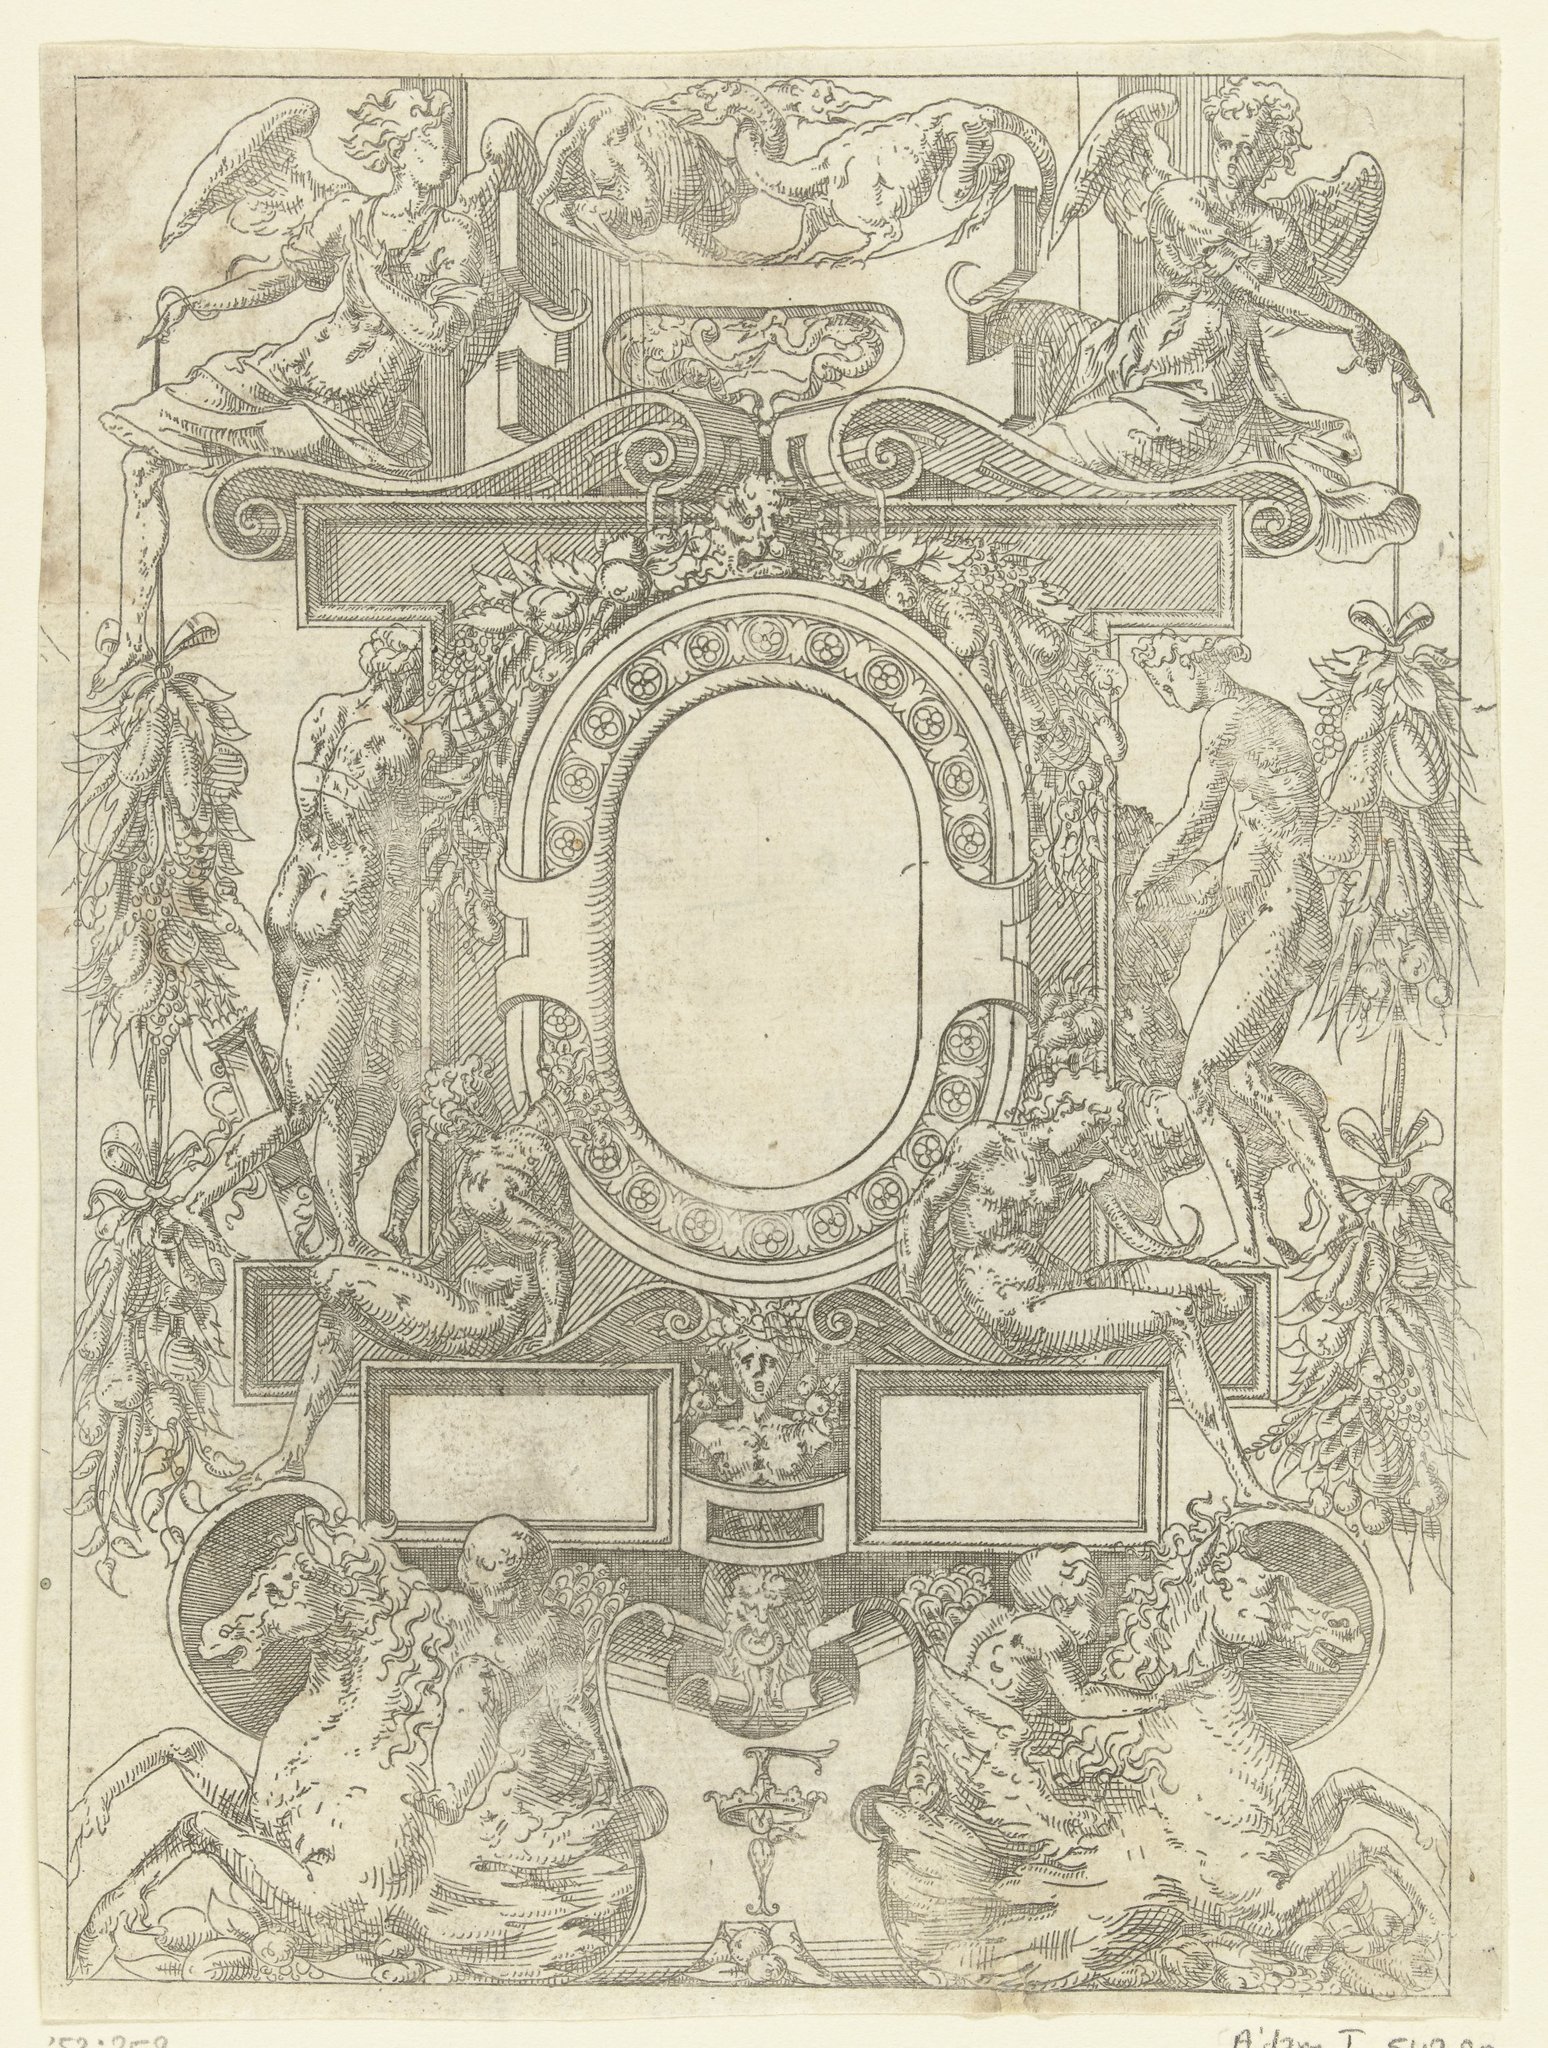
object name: print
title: Kleine cartouche naar voorbeeld te Fontainebleau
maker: Anonymous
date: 1520-1584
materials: paper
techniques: etching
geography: italy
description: Linksonder en rechtsonder rijdt een putto op een gevleugeld paard. Uit serie van 32 bladen. De cartouches zijn deels ontleend aan de prenten van Antonio Fantuzzi naar de decoratie van de Galerie van François 1er door Giovanni Battista Rosso. De serie staat ook bekend onder de titel Petits cartouches de Fontainebleau.